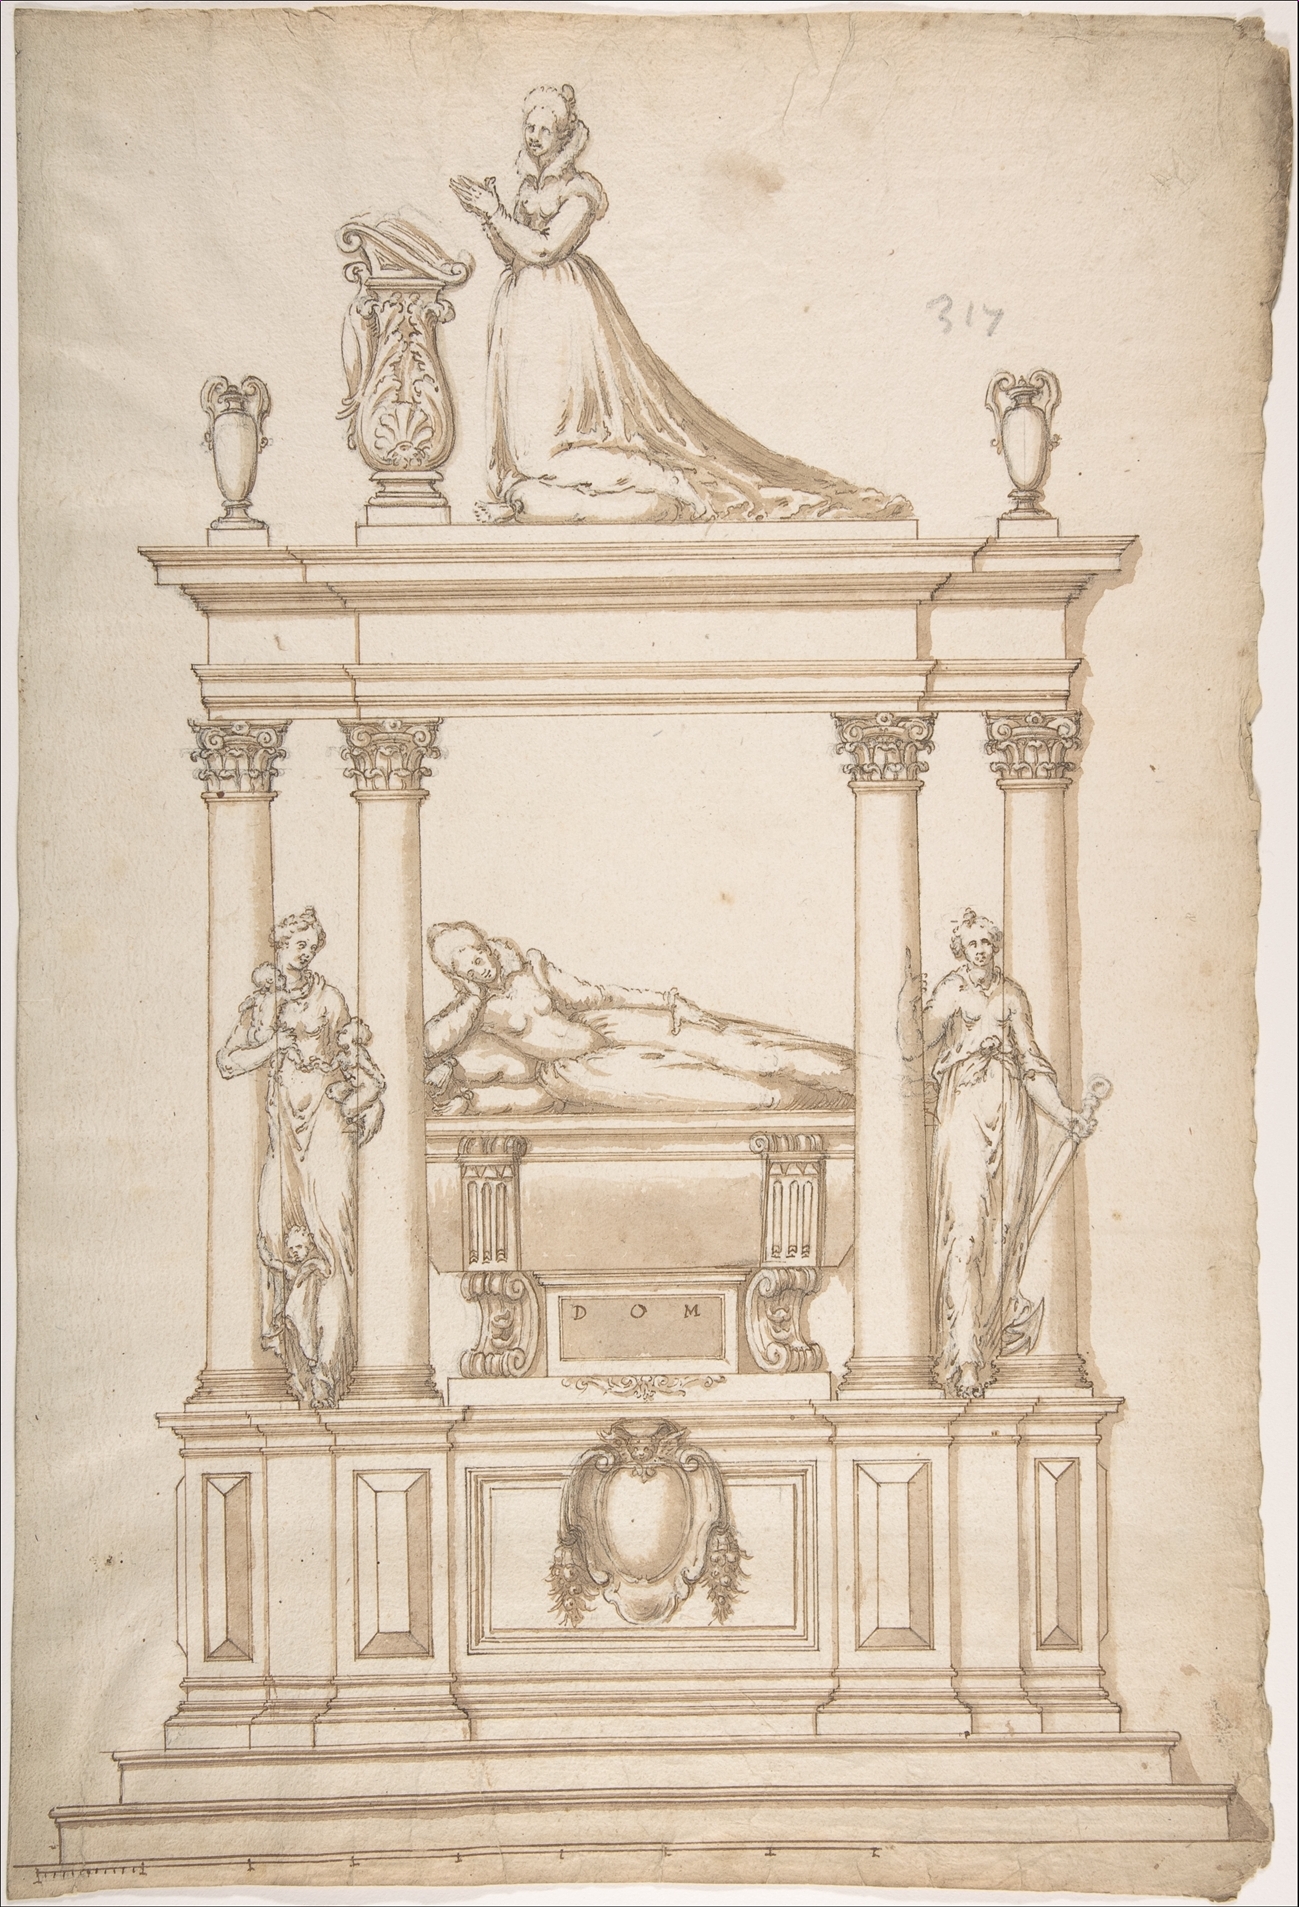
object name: drawing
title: Design for a Woman's Tomb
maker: anonymous, french, 16th century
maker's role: artist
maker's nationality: french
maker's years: 1500-1600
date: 1501-1600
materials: chalk, ink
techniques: brush, pen, wash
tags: architecture,tombs,women